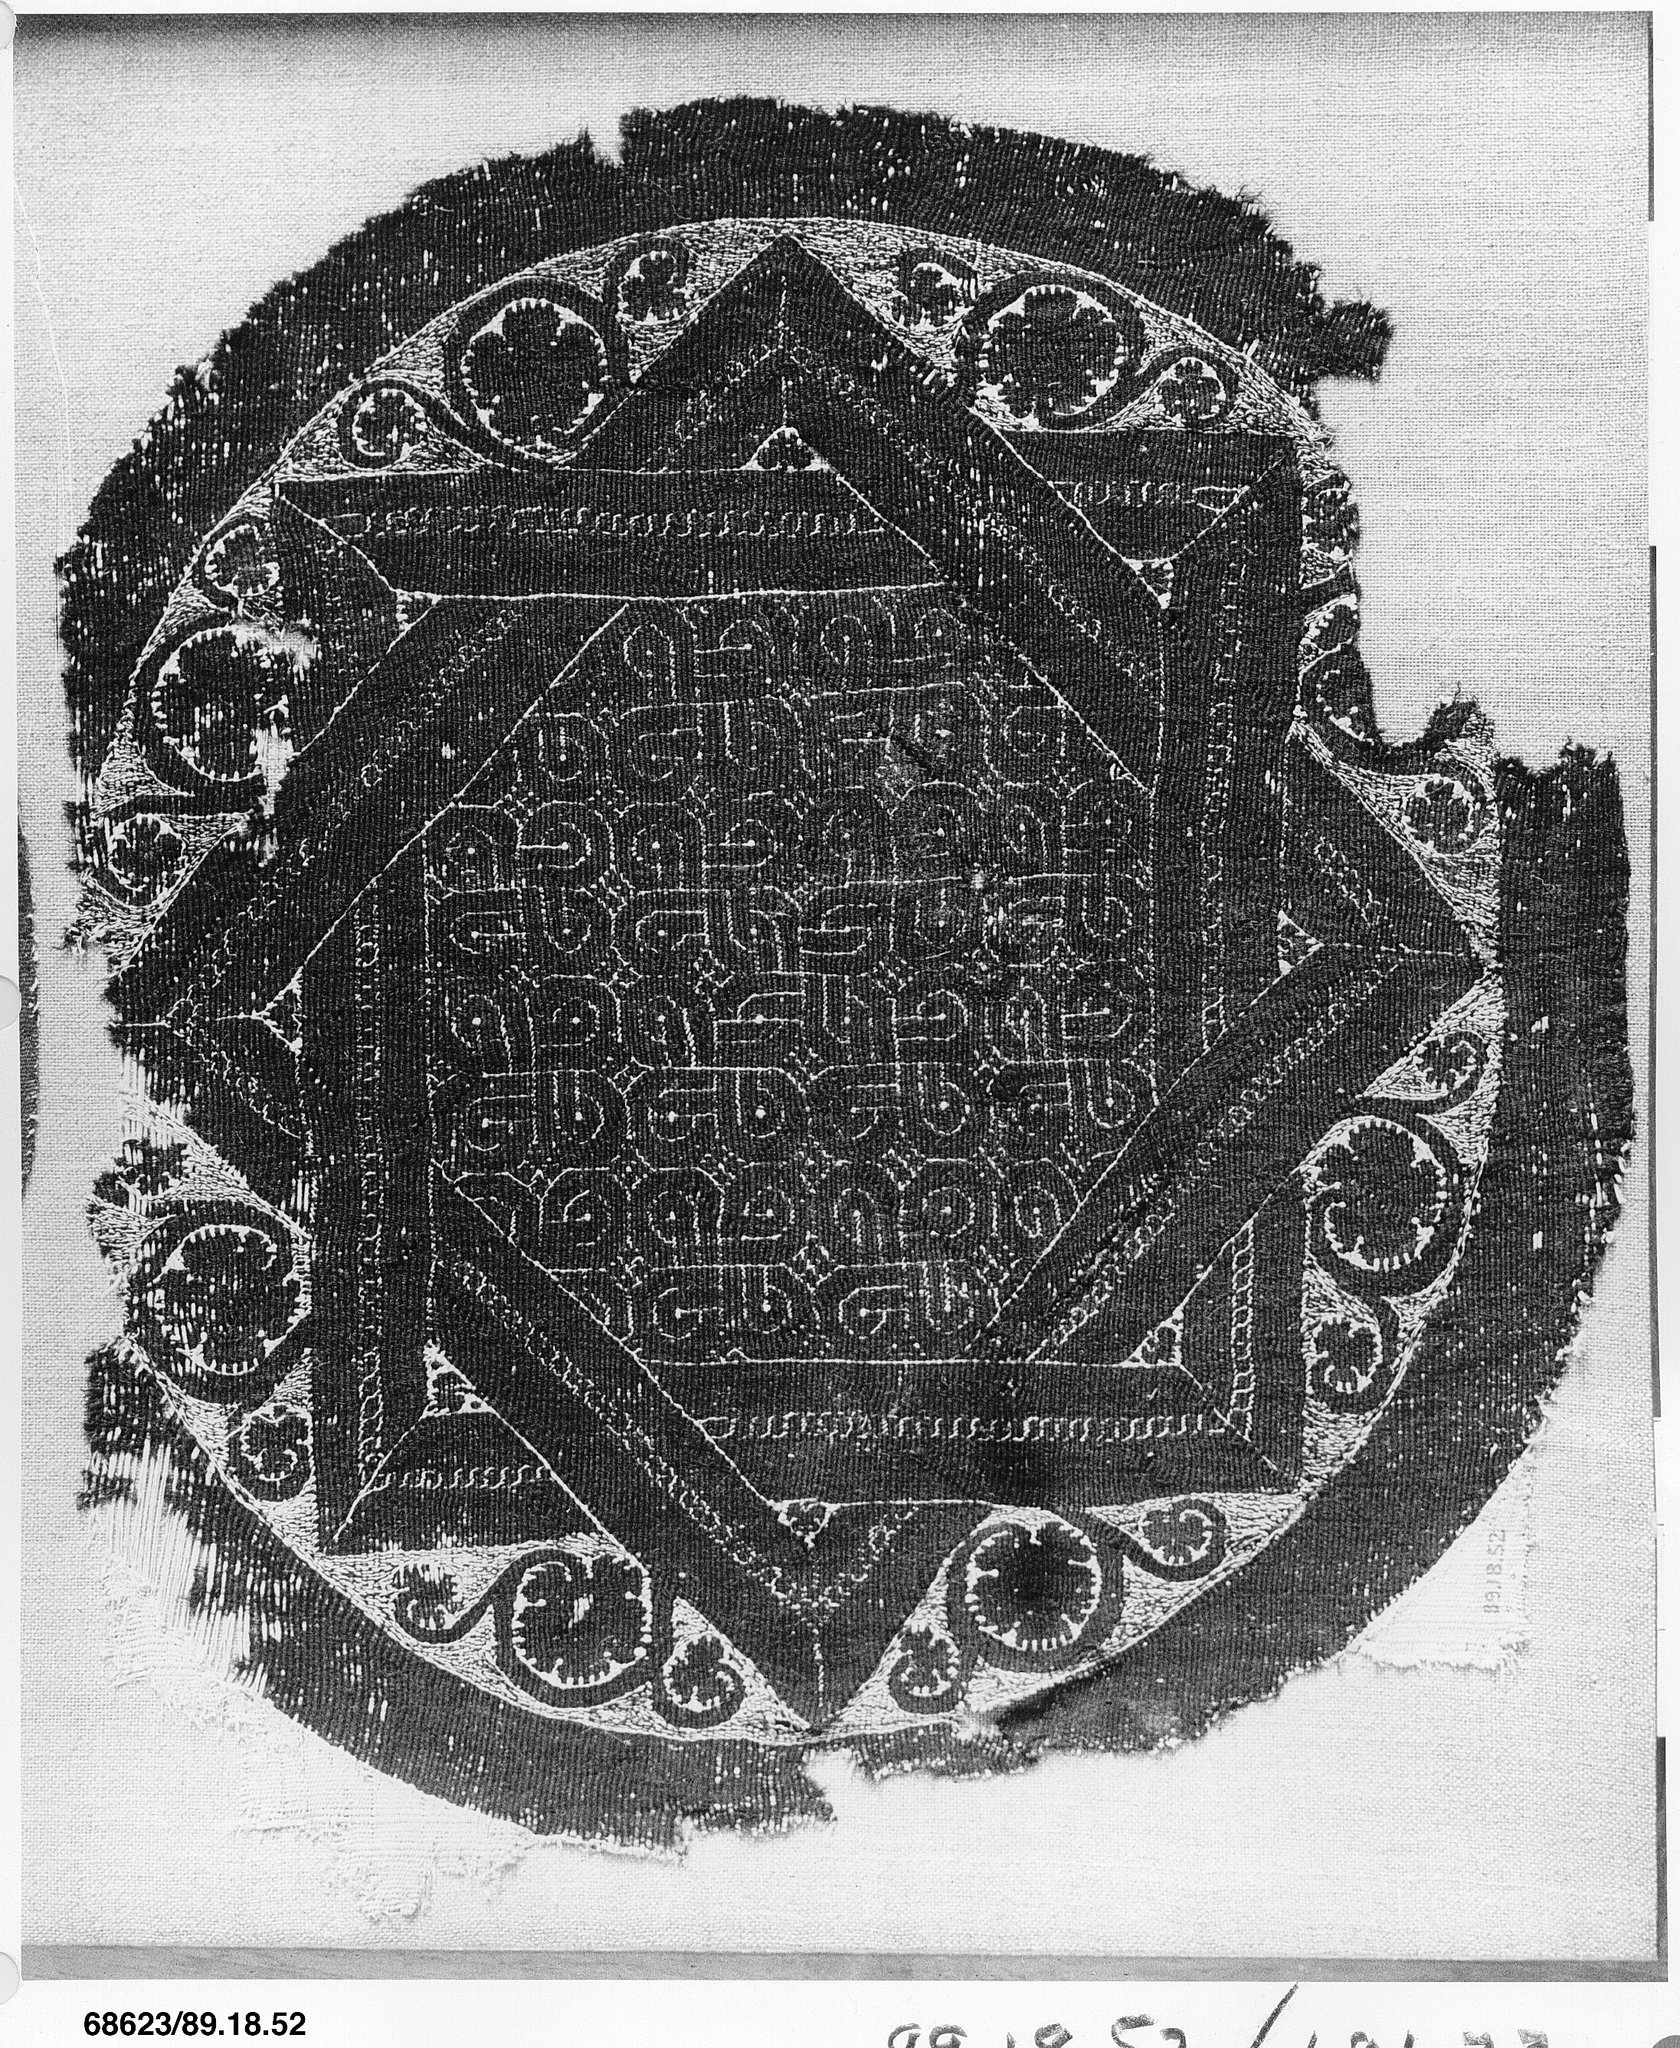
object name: textile fragment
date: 201-400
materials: linen, wool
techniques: weave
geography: egypt